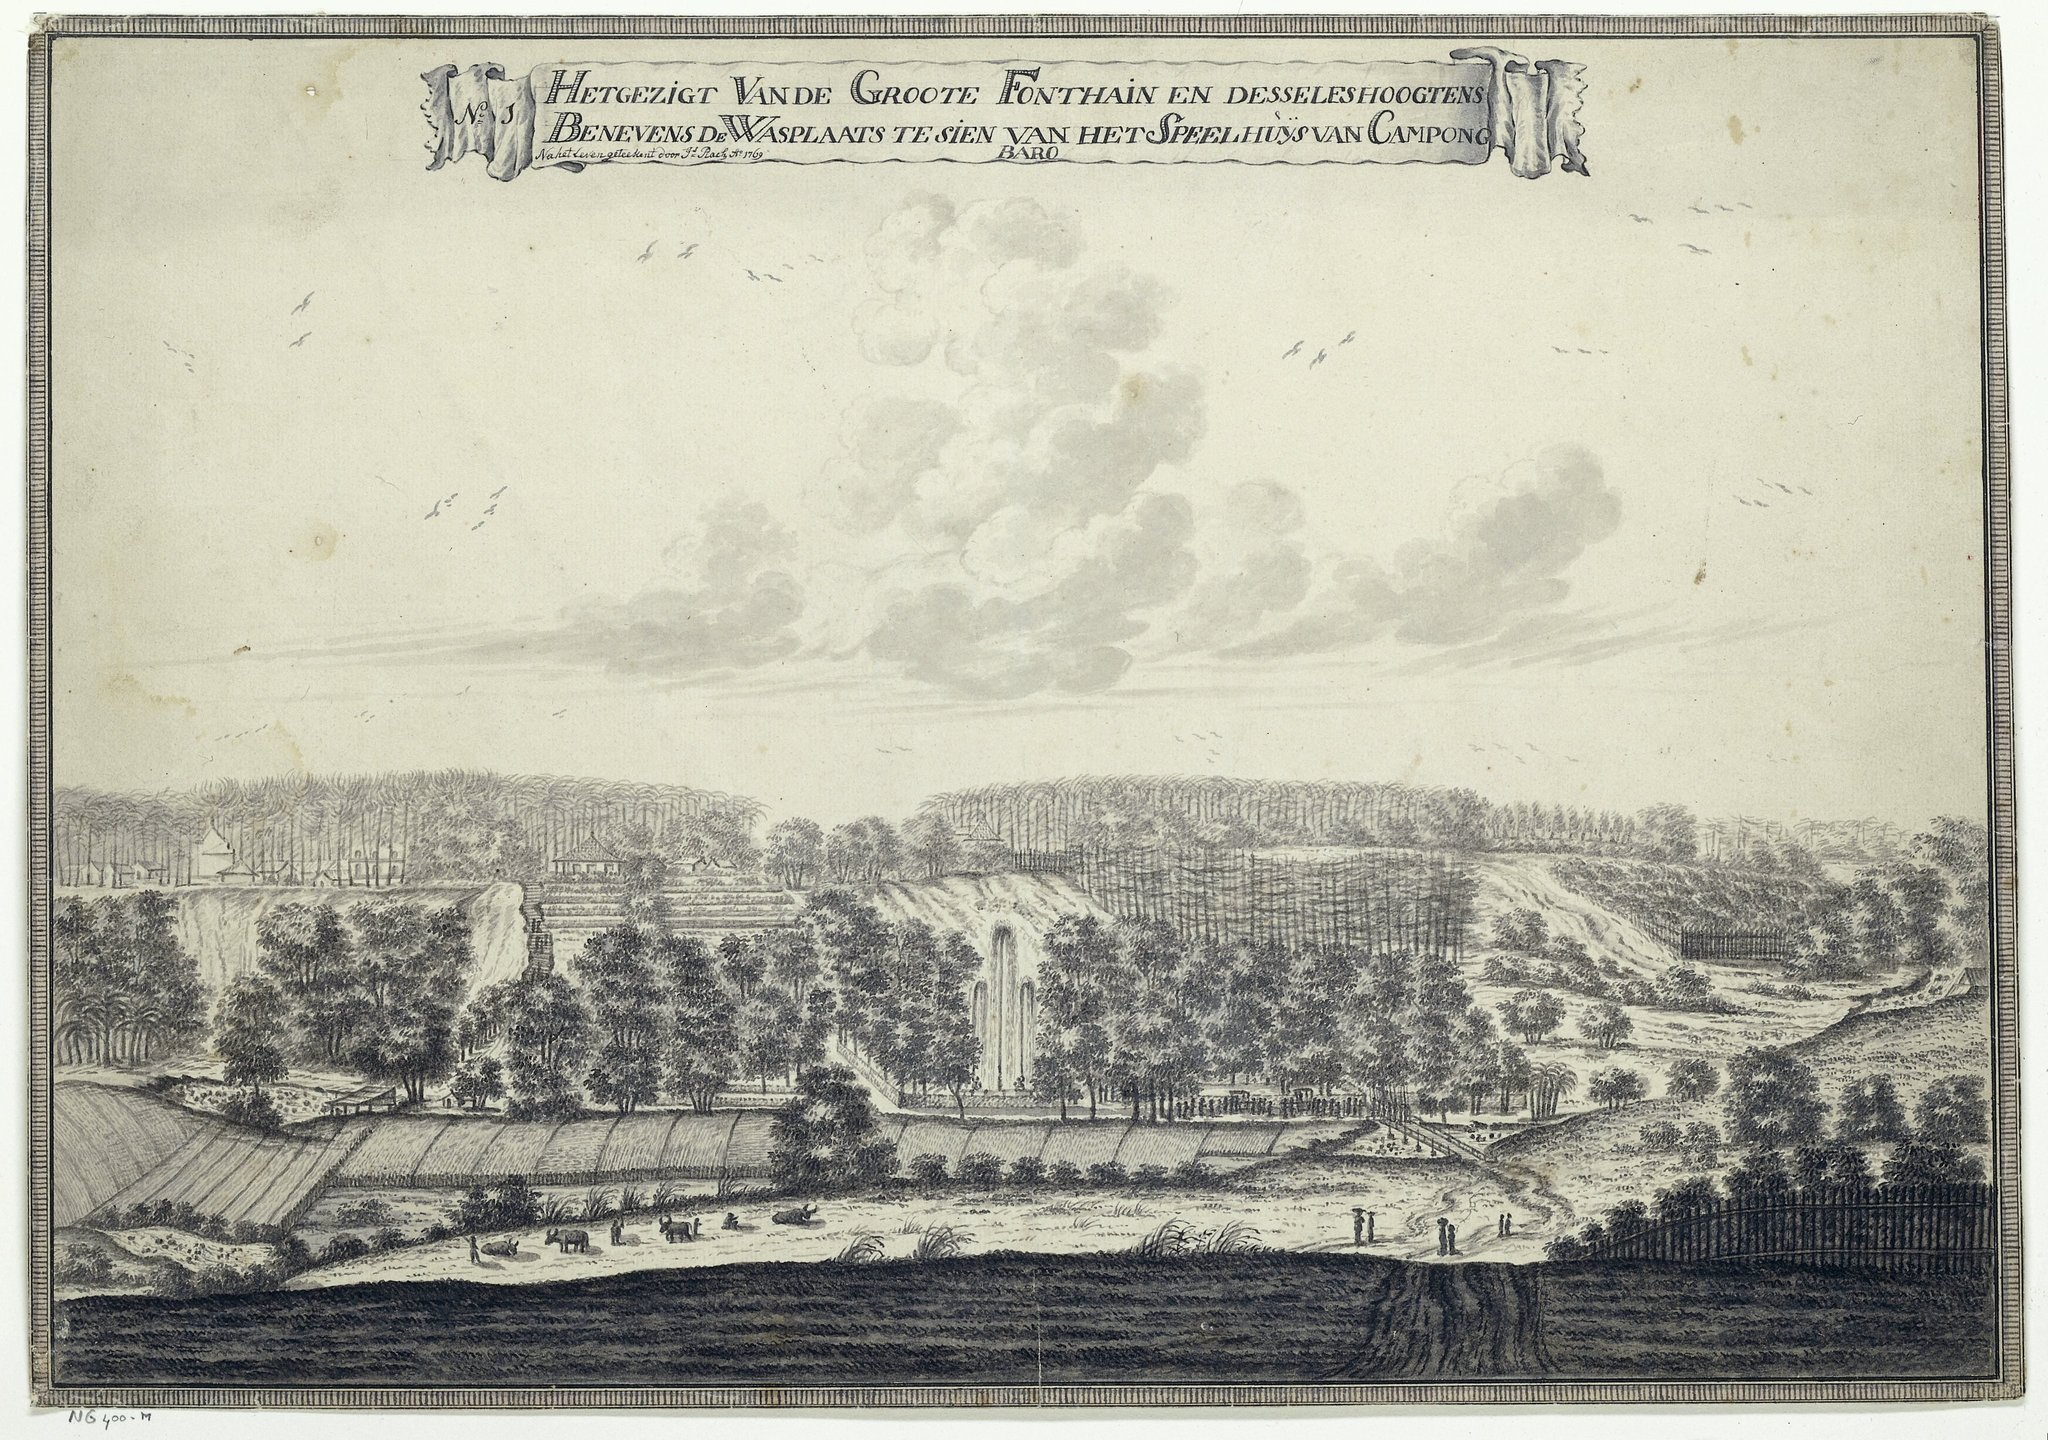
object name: drawing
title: Het gezigt Van de Groote Fonthain en desselfs hoogtens Benevens de Wasplaats te sien van het Speelhuijs van Campong Baro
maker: johannes rach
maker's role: draughtsman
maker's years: 1720-1783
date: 1769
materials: ink, paper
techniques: brush, pen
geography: dutch east indies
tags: park, garden fountain, dutch east indies, the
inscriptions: date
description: Gezicht op een dal met rijstvelden en bomen. Linksonder enkele koeien en mensen; rechts enkele verspreide mensen en een stoet bij een bruggetje. In het midden spuit een fontein drie stralen boven de bomen uit. Op achtergrond palmbomen en huizen.